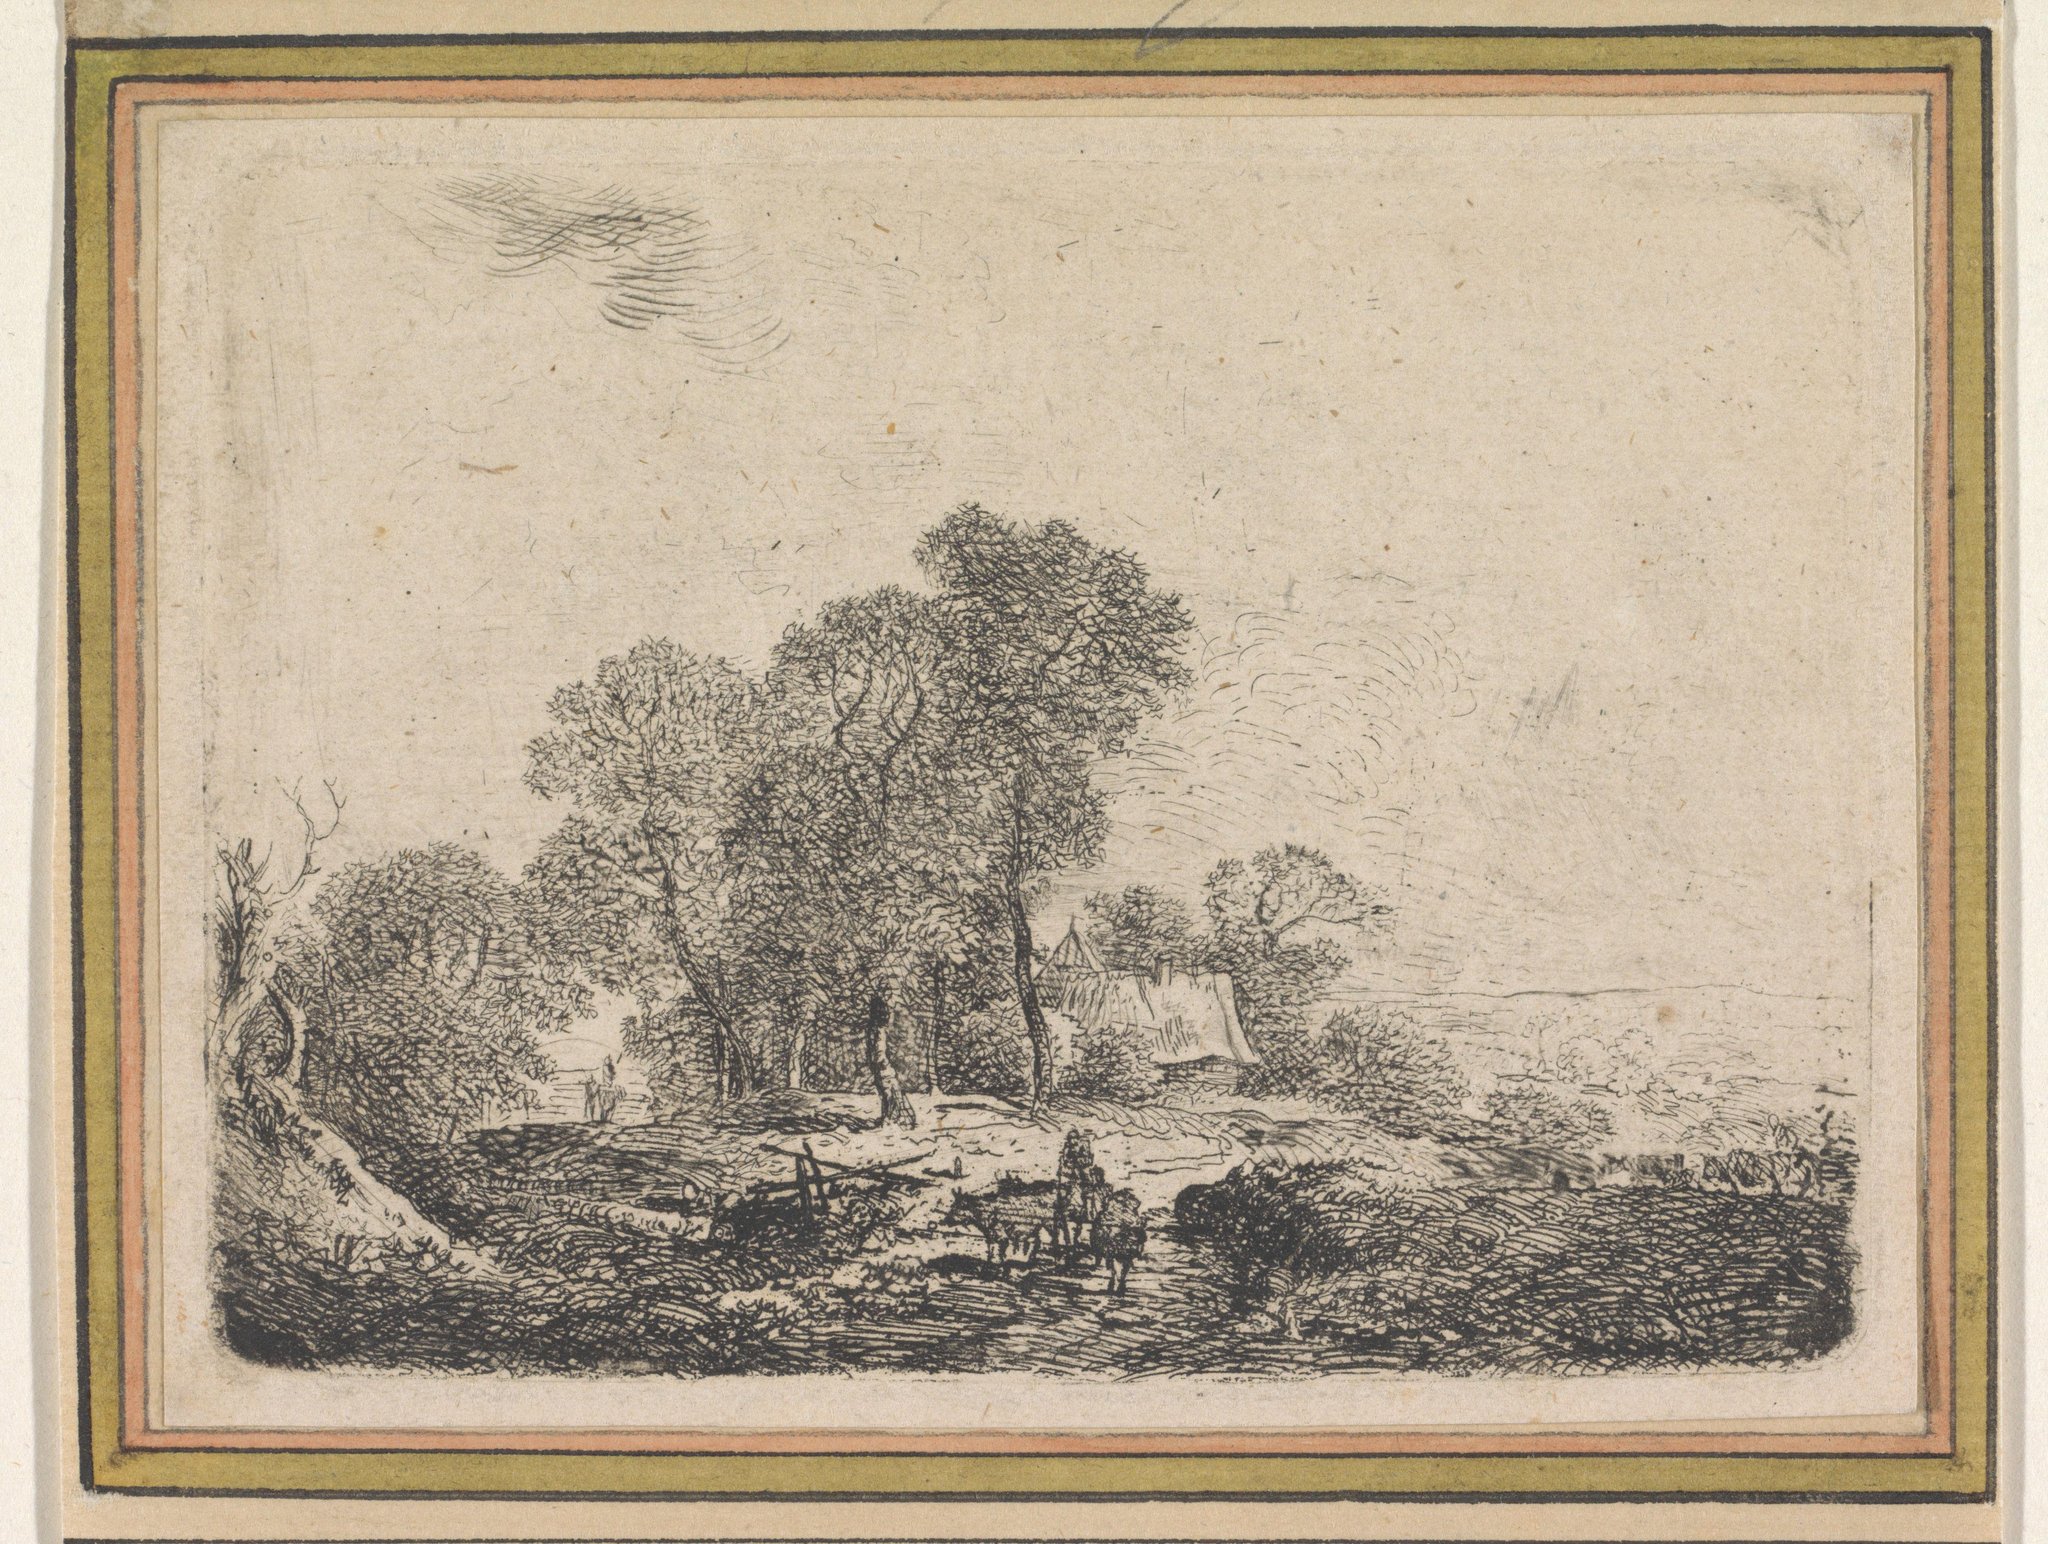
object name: print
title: Landschap met veehoeder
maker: Anonymous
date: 1600-1700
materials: paper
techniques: etching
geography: netherlands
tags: farm or solitary house in landscape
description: Landschap met op de voorgrond een veehoder met beesten. Tussen hoge bomen ligt een boerderij.